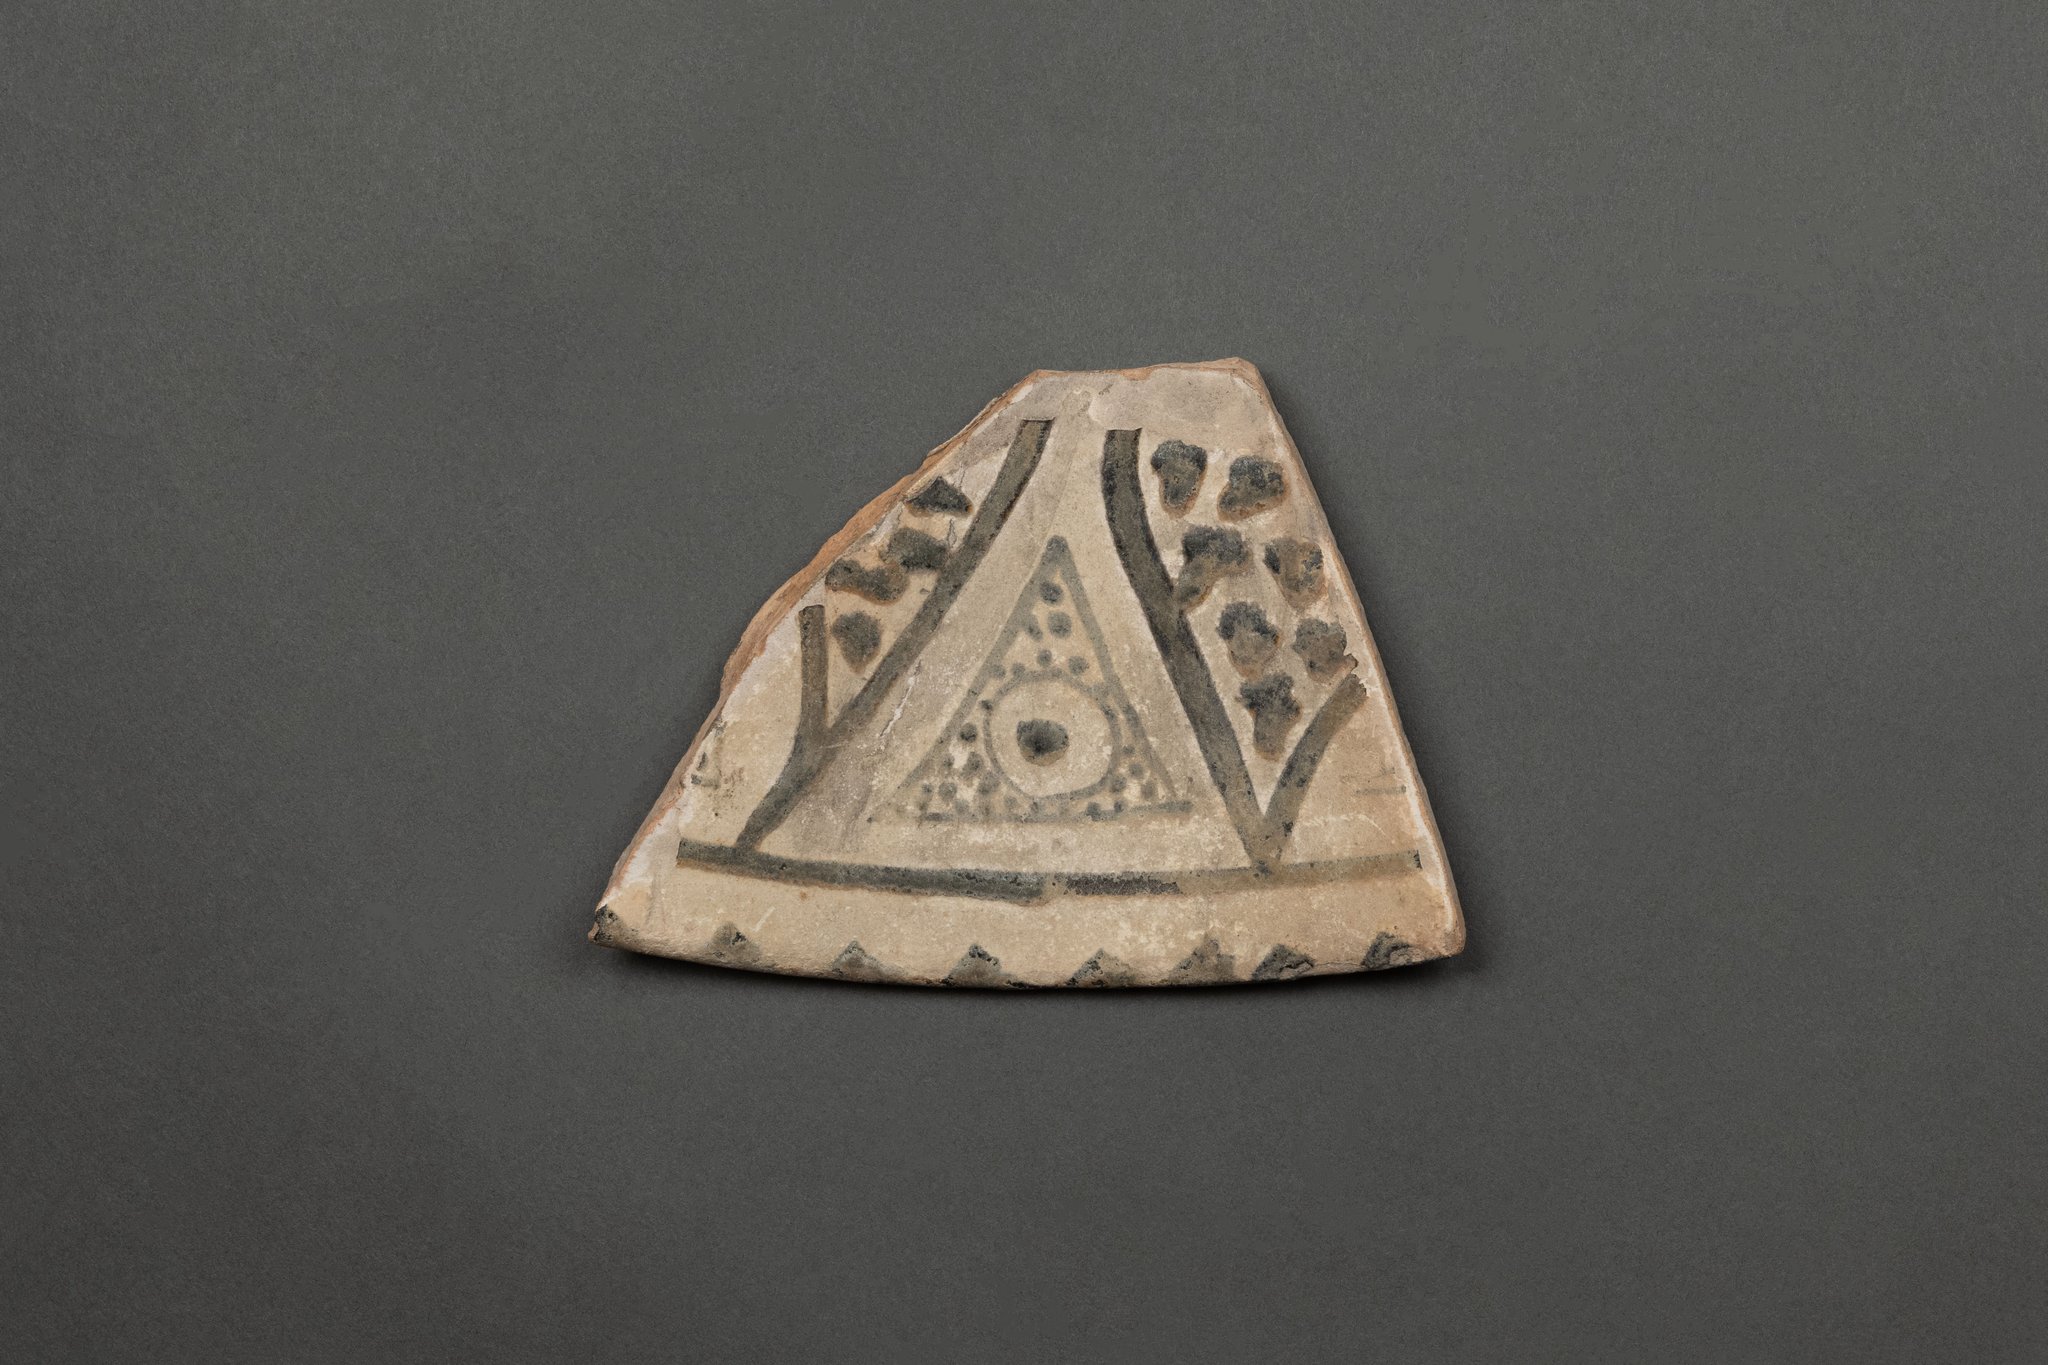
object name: fragment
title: Fragments of a Bowl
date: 801-1000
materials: earthenware, glaze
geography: iran